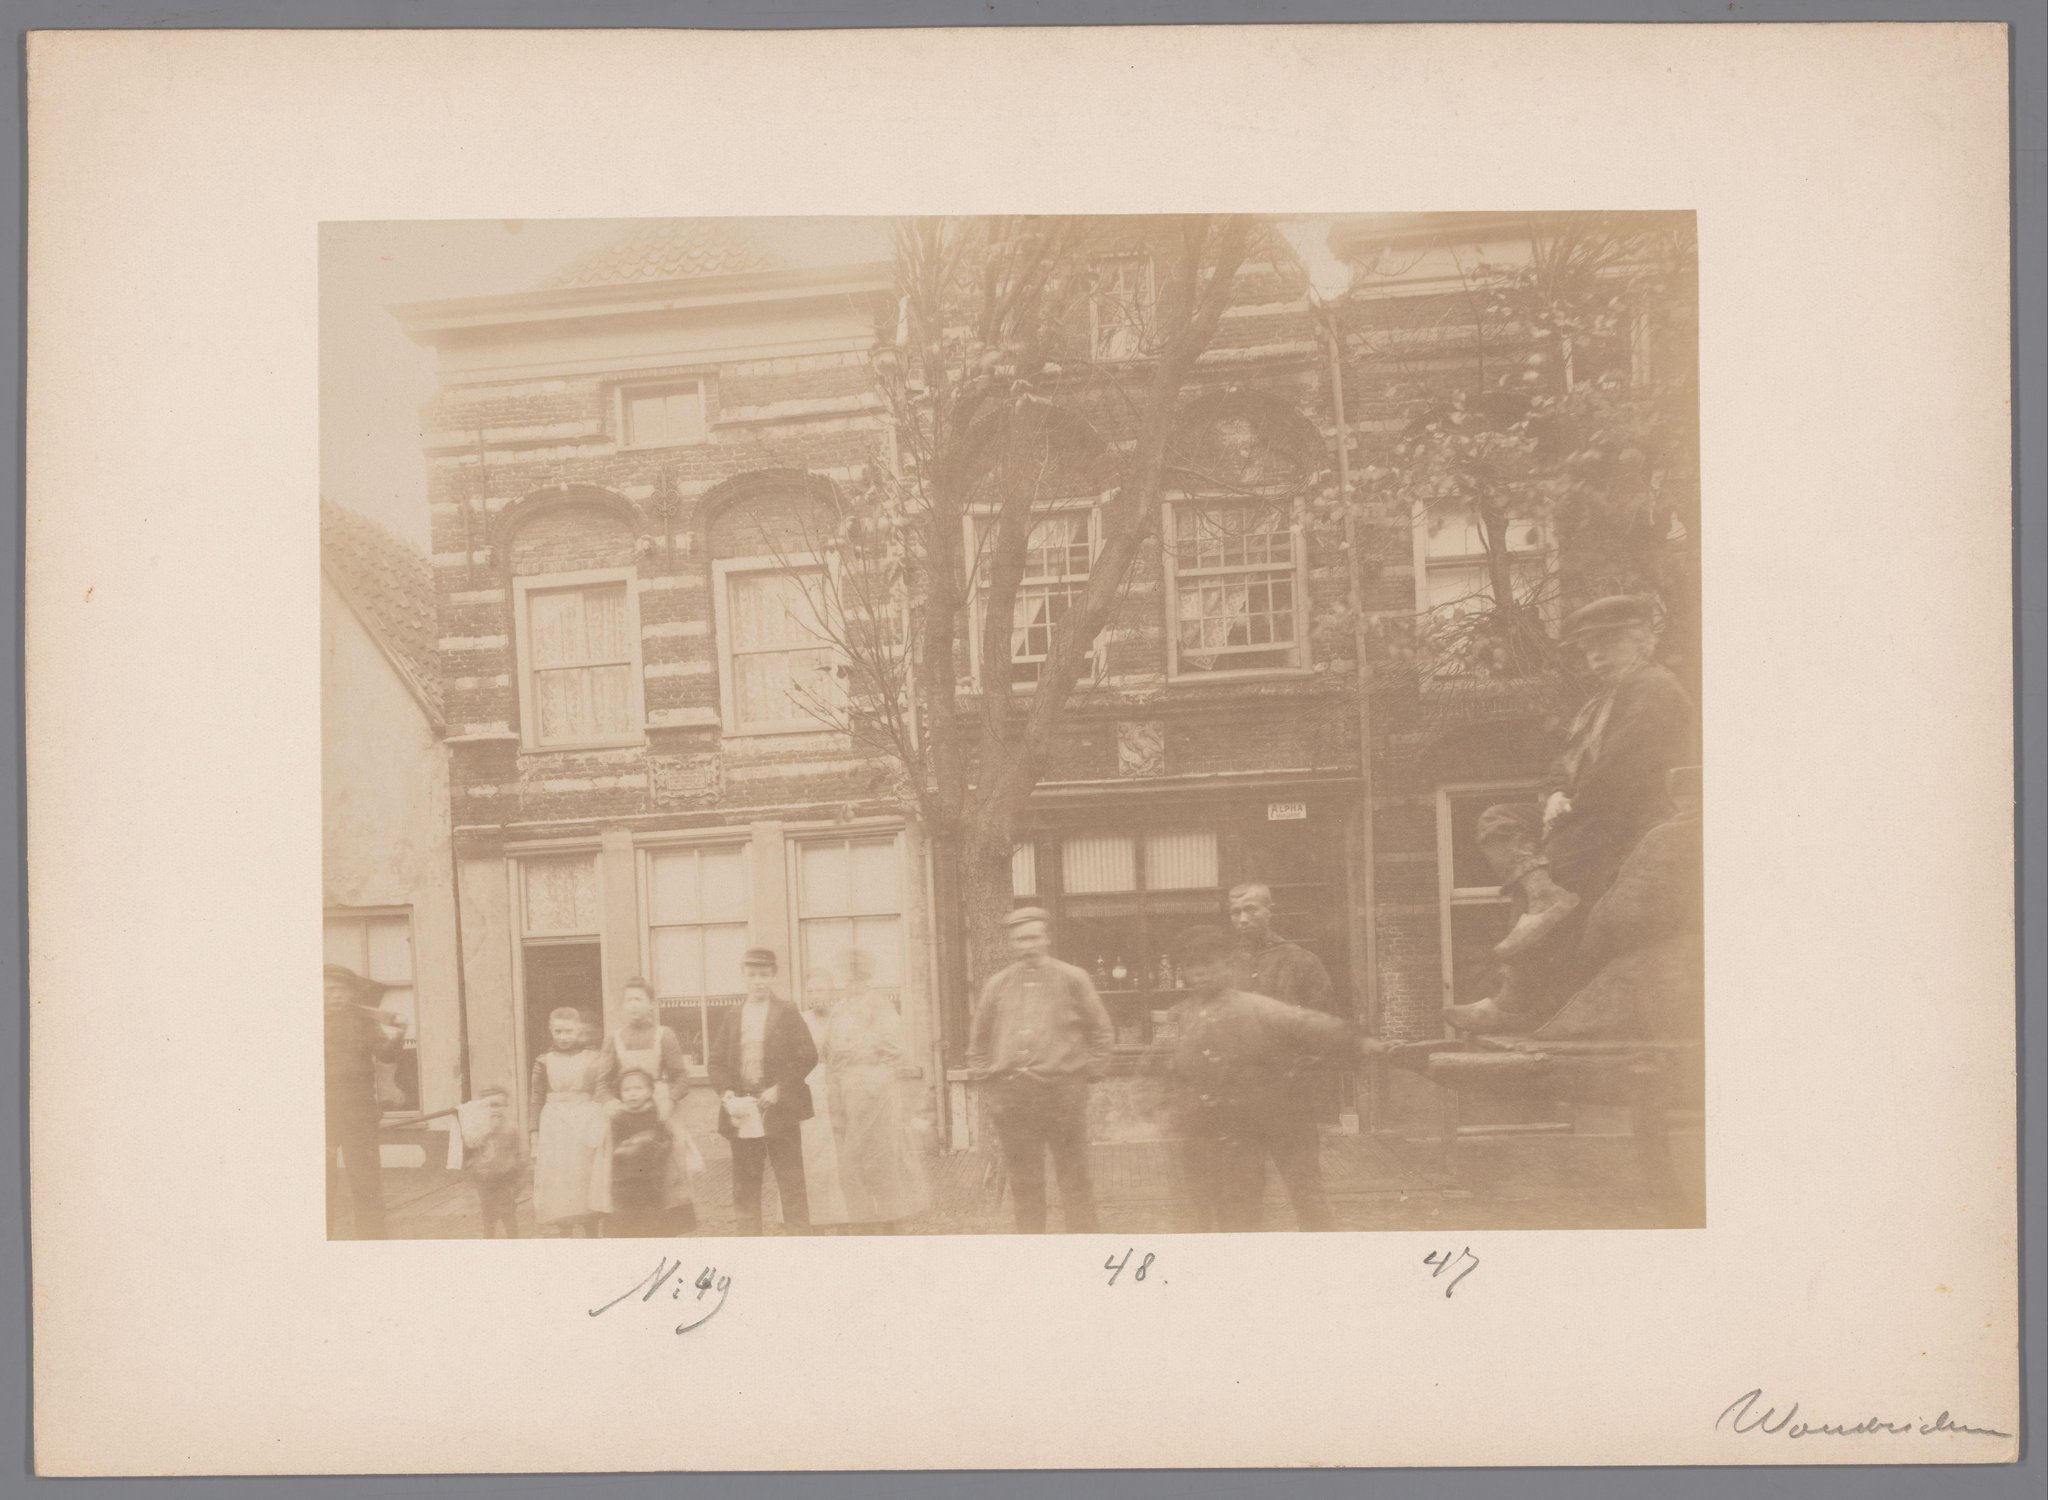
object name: photograph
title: Gezicht op Hoogstraat 47-49 te Woudrichem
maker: anoniem (monumentenzorg)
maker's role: fotograaf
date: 1901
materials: cardboard, photographic support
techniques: albumen print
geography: woudrichem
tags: urban housing, façade (of house or building), street (+ city(-scape) with figures, staffage), woudrichem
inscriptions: annotation: ‘Woudrichem oct 1901 (N.B.)/ Hoogstraat N:47 48-49’, annotation: ‘Woudrichem/ N:49 48 47’